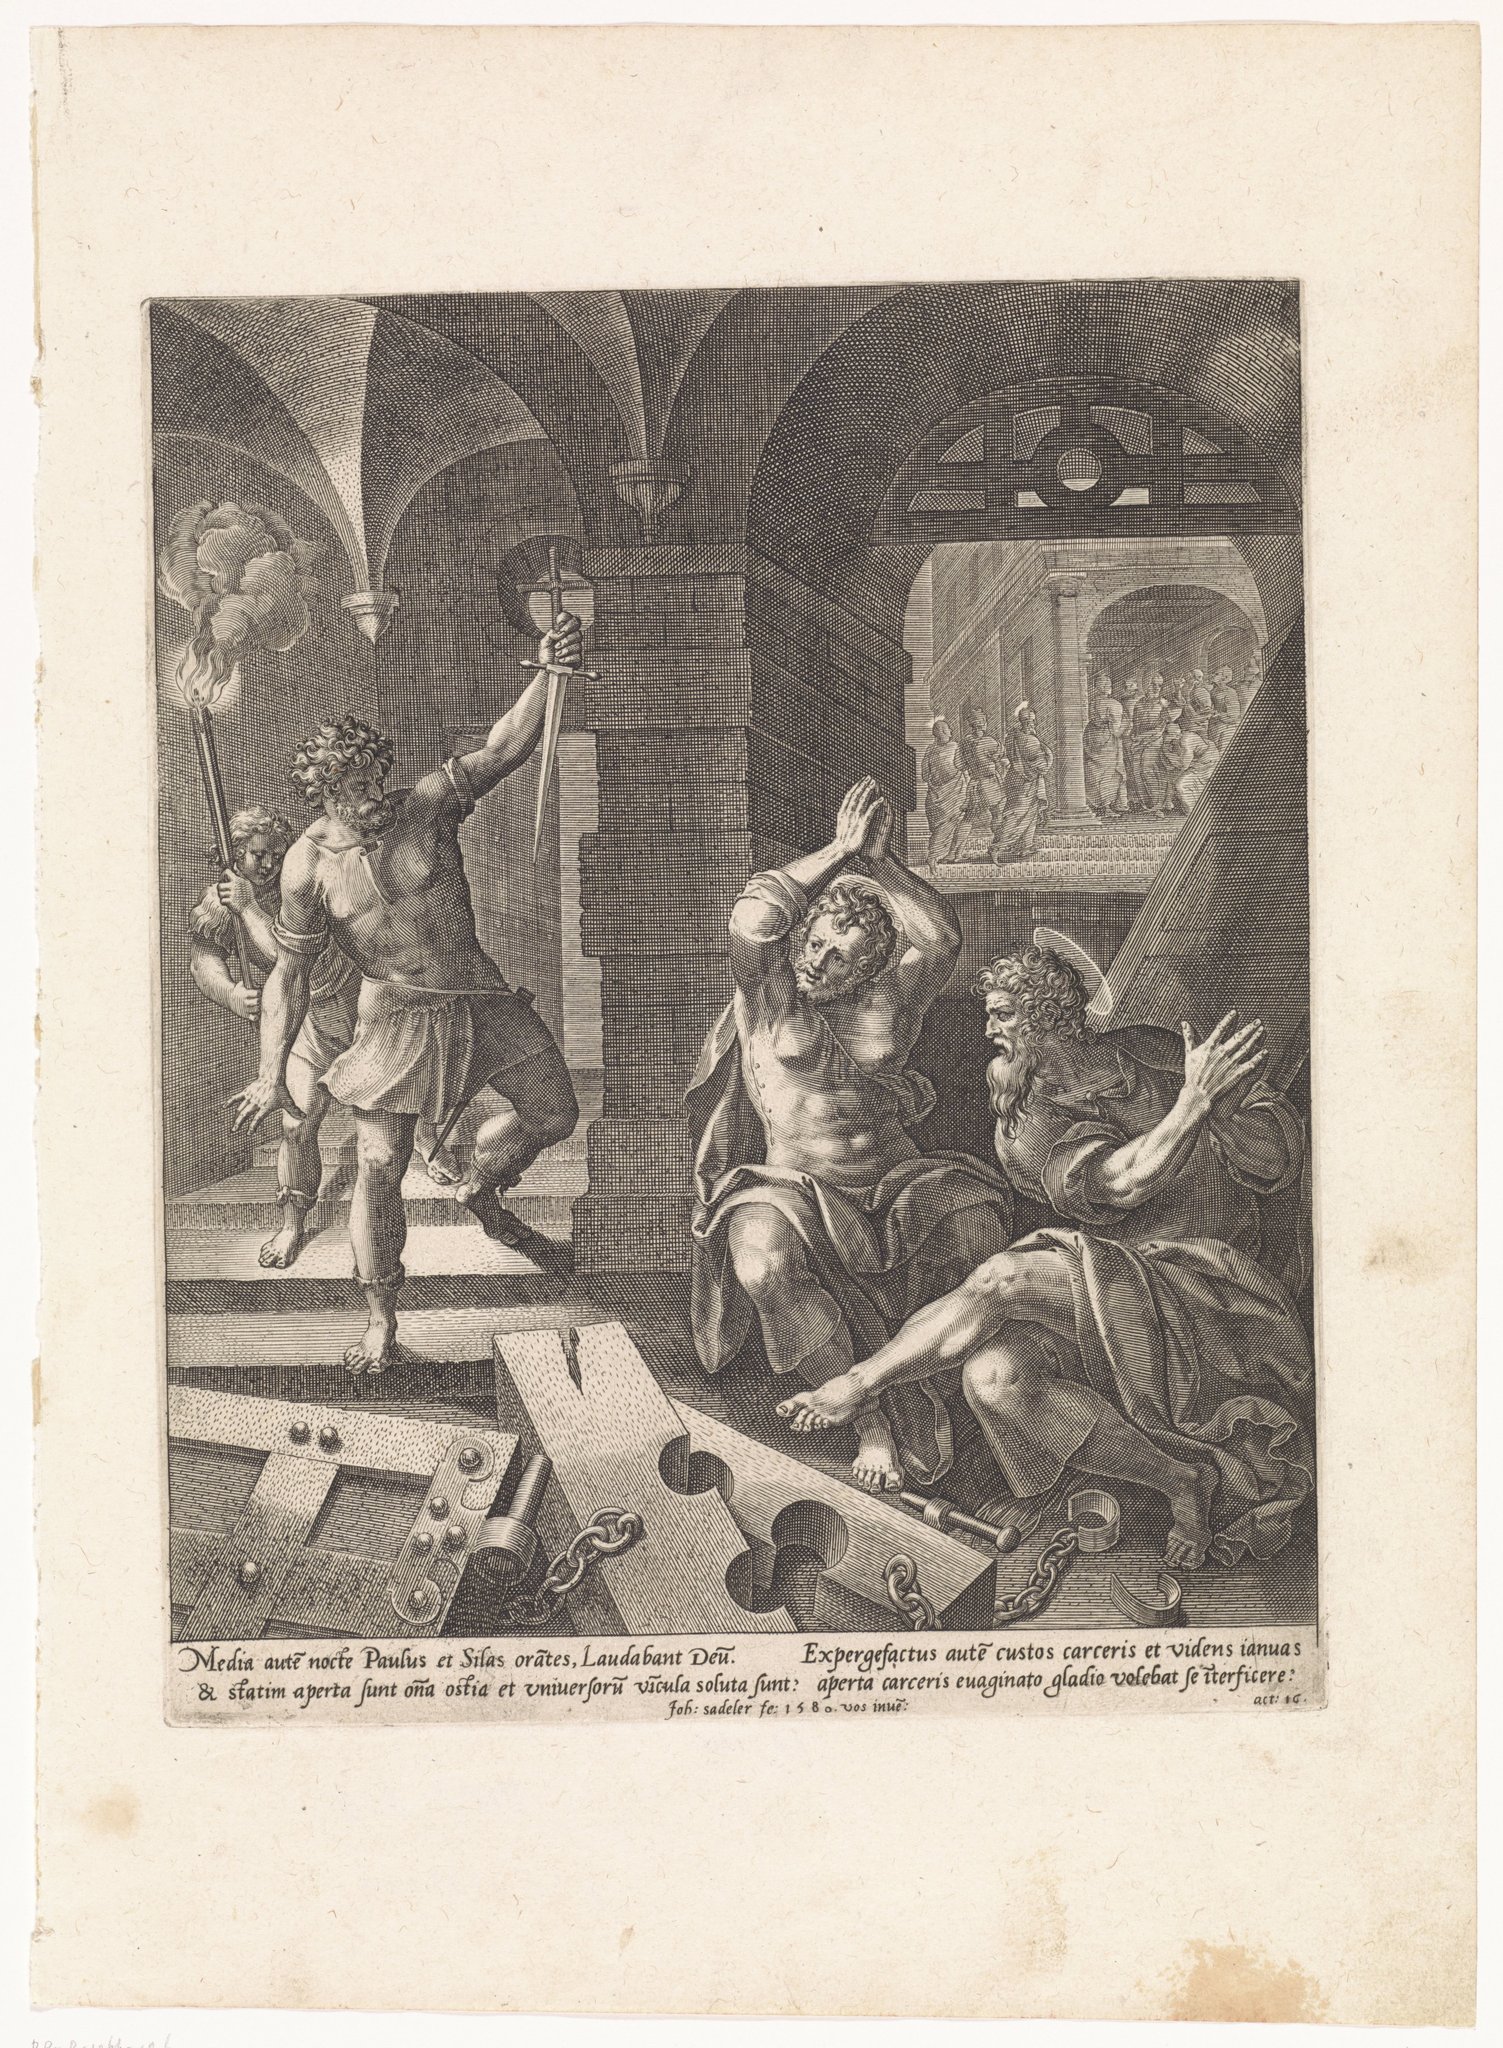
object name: print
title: Scènes uit het leven van de apostel Paulus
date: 1580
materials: paper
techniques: engraving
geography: cologne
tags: the prison-doors are opened by an earthquake ~ paul and silas in prison, paul and silas thrown into prison, paul and silas prevent the warder from committing suicide (story of the conversion of the warder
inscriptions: collector's mark: Lugt 2228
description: Op de voorgrond poogt de gevangenenbewaarder van Filippi zelfmoord te plegen wanneer hij merkt dat de gevangenisdeuren open zijn. Hij vreest dat de gevangen zullen zijn ontsnapt. De apostel Paulus en zijn gezel Silas zijn echter in de cel blijven zitten. Paulus bekeert de gevangenenbewaarder vervolgens. Op de achtergrond de veroordeling van Paulus en Silas. Met een Latijns onderschrift met een Bijbelpassage uit de Handelingen van de Apostelen (Hand. 23). De eerste prent van een vierdelige serie.